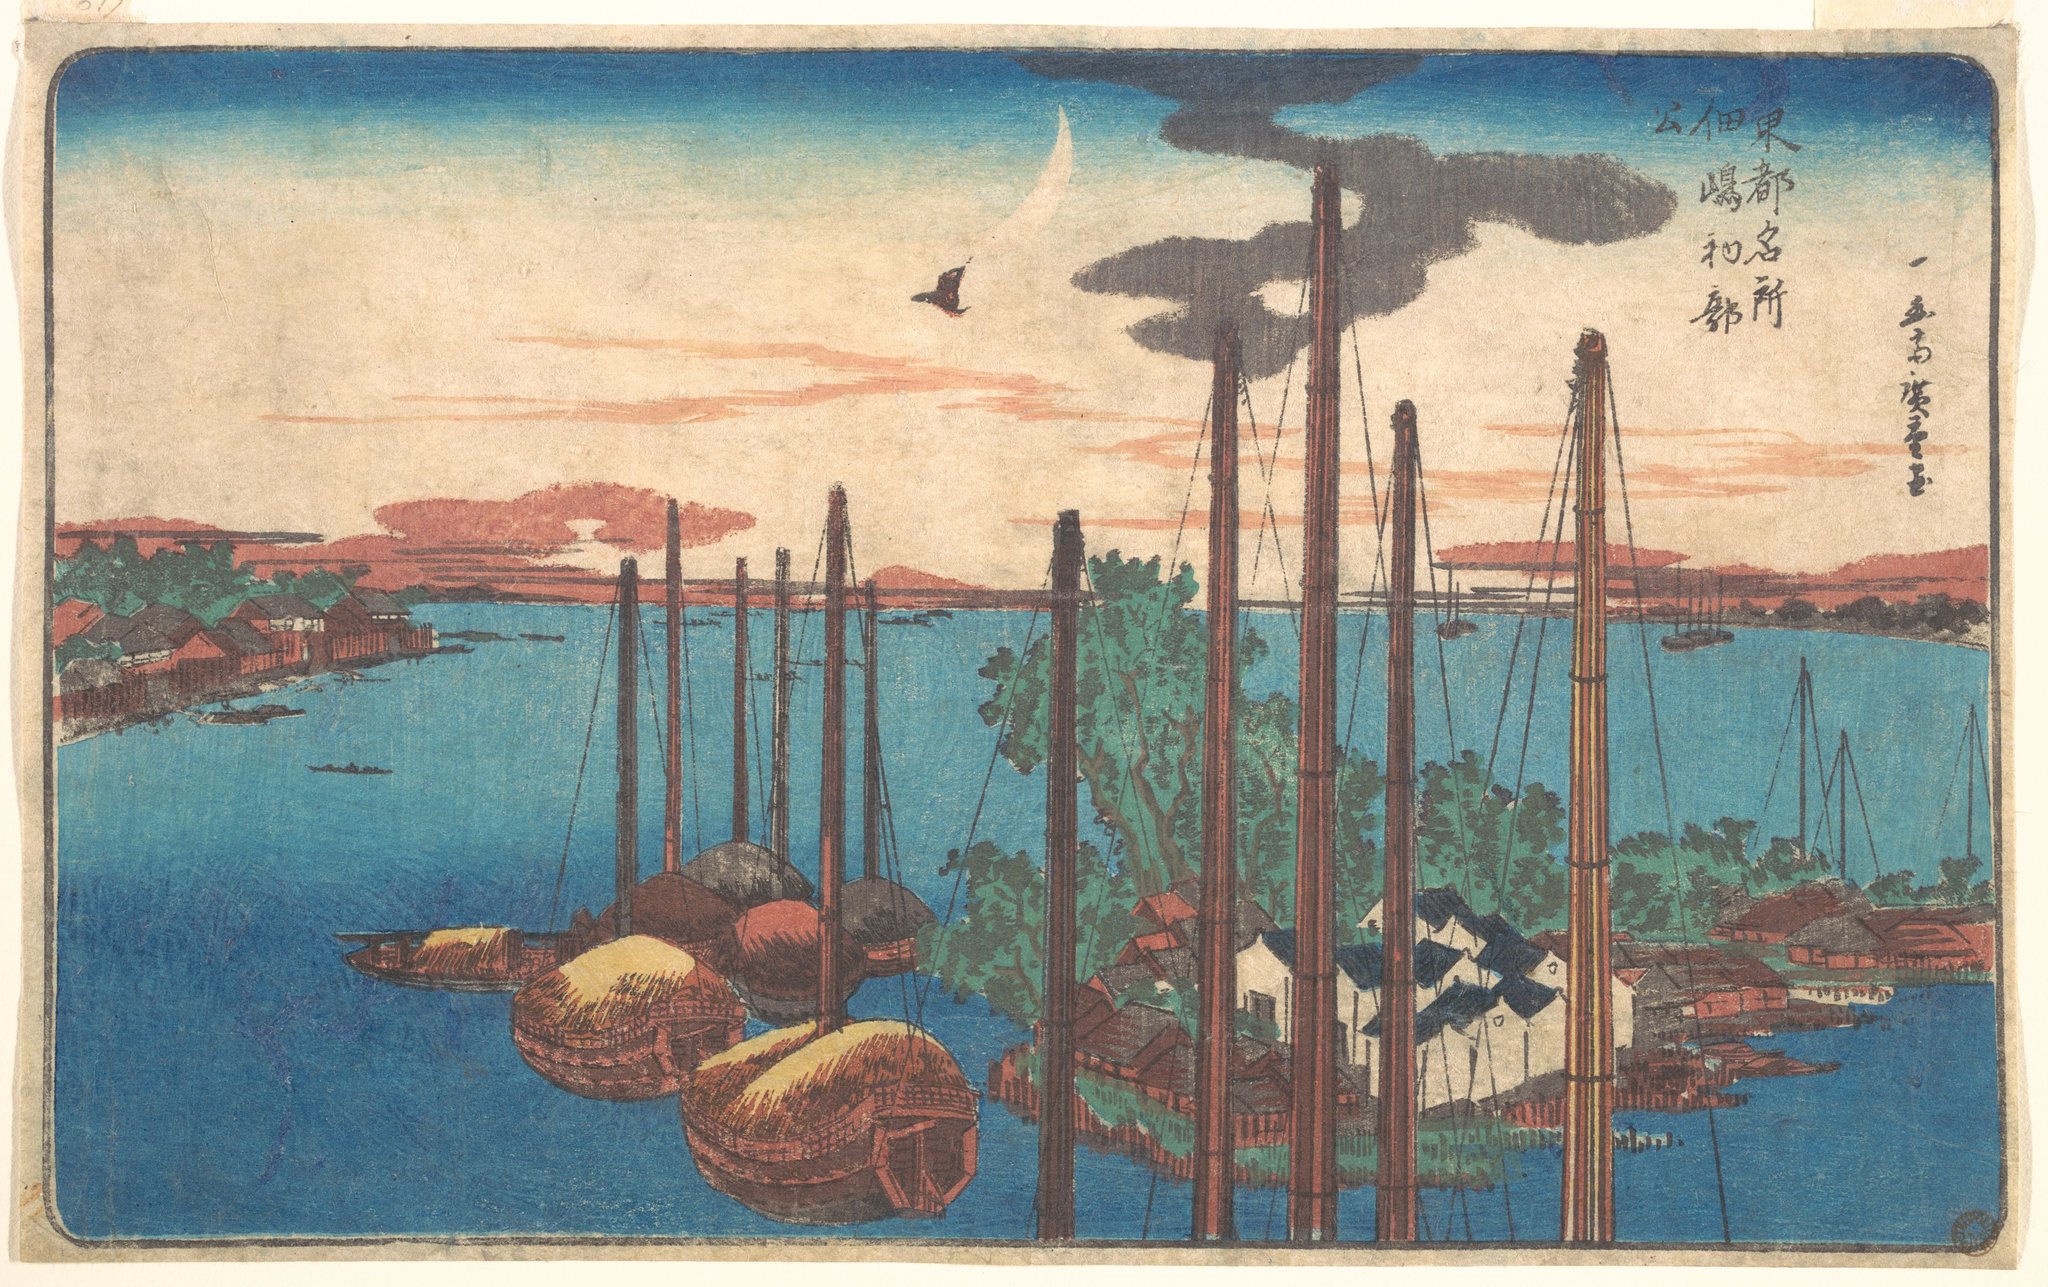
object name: print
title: Tsukudajima Hatsu Hototogisu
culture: japanese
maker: utagawa hiroshige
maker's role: artist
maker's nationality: japanese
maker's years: 1797-1858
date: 1830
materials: ink, paper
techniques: woodblock print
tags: buildings,boats